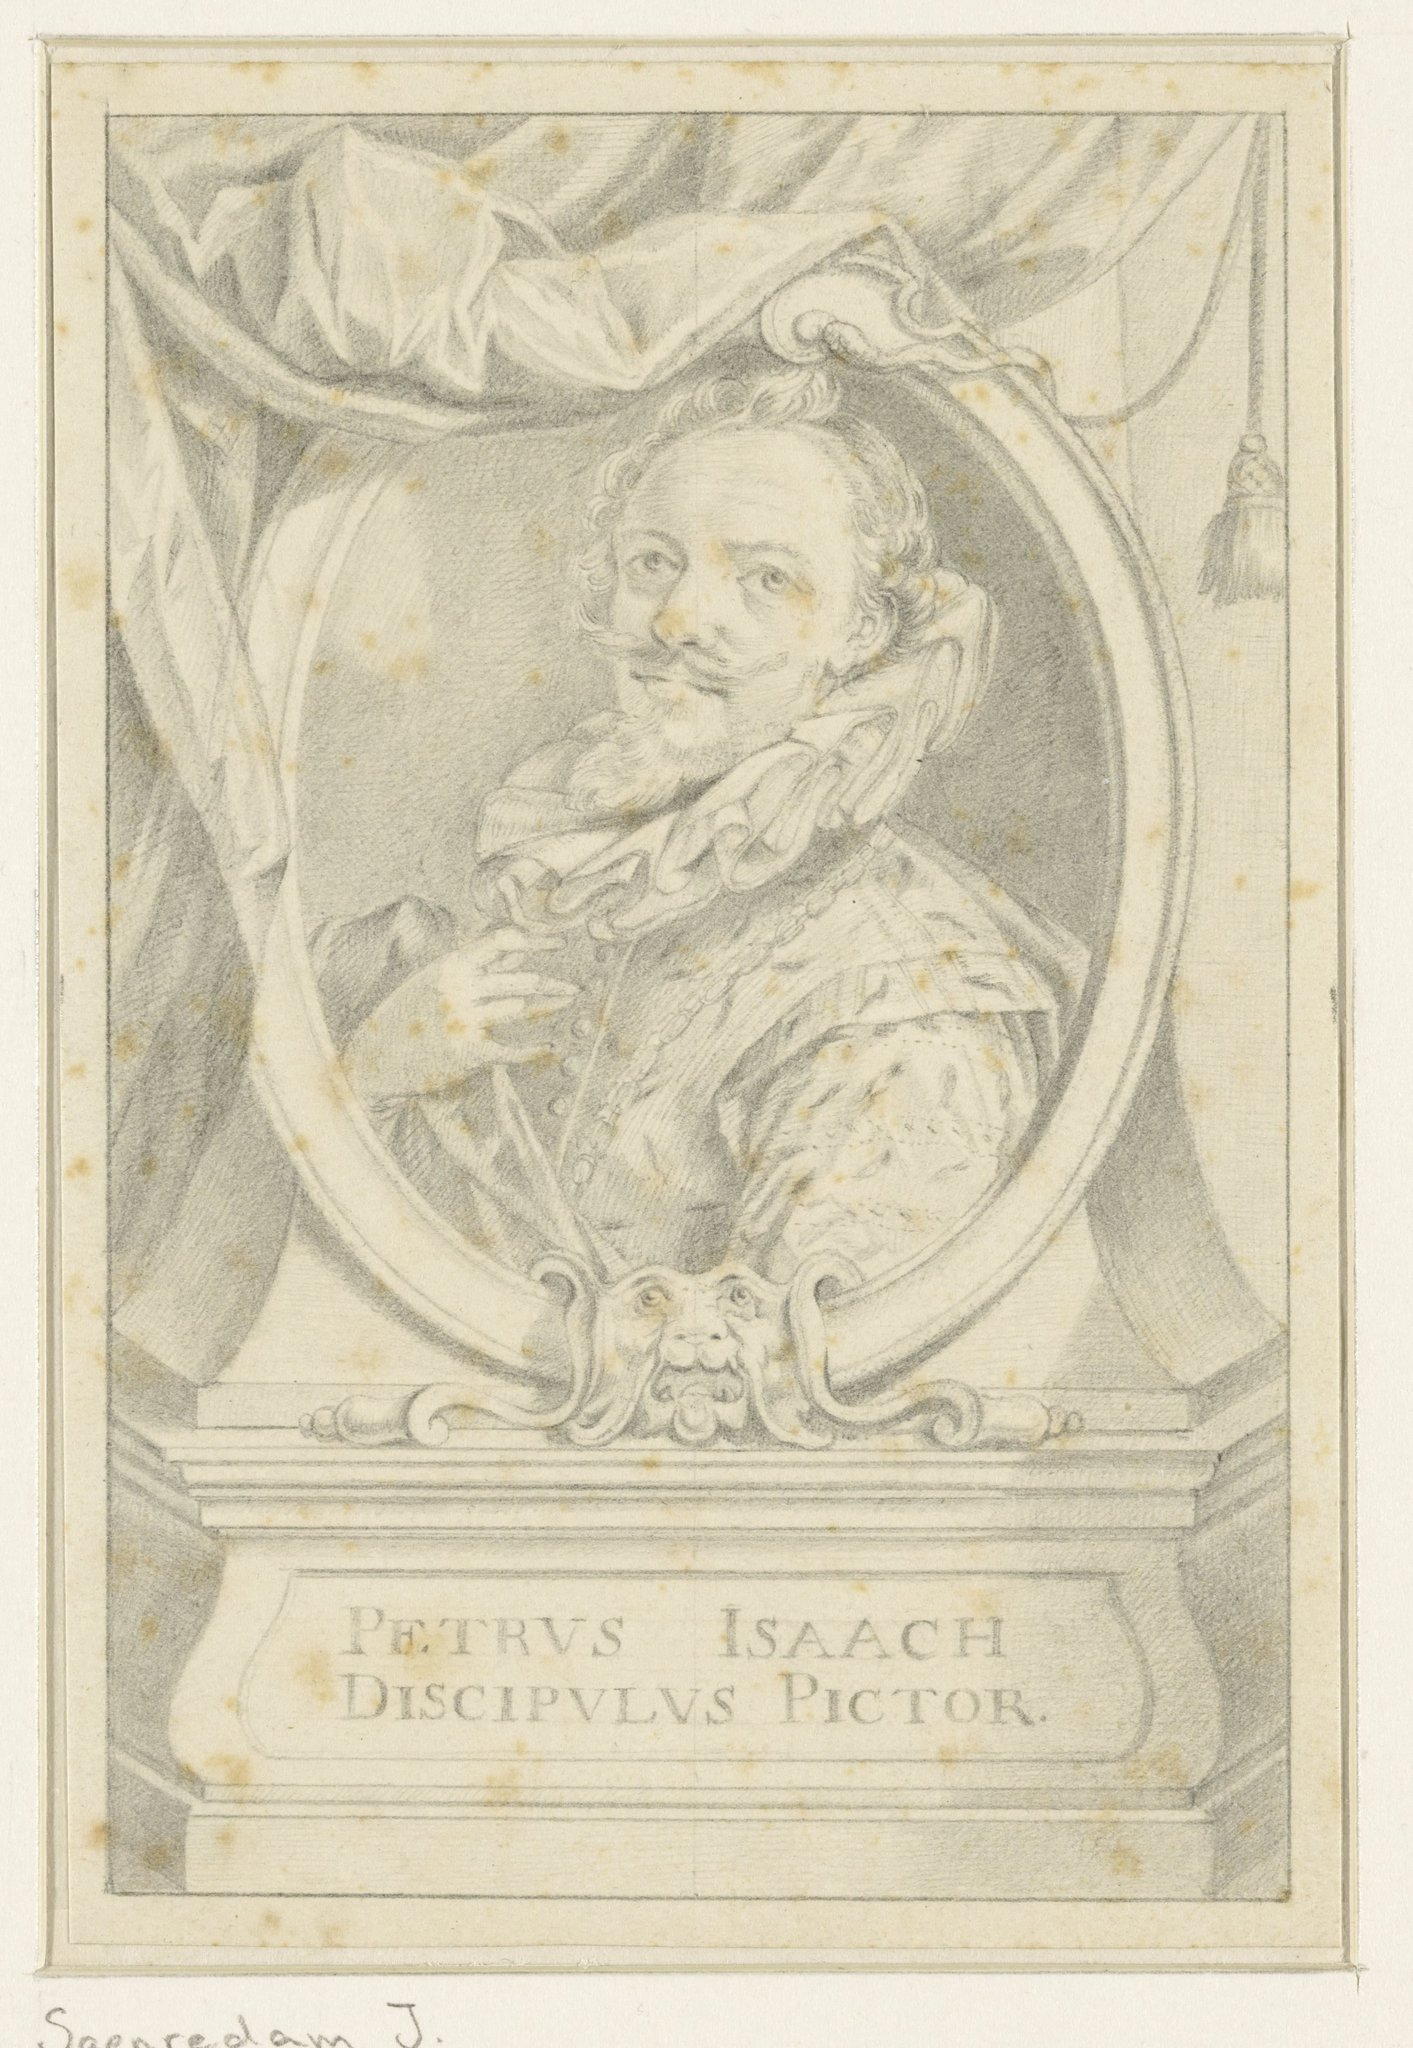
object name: drawing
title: Portret van Hans von Aachen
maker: Anonymous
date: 1601-1700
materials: paper, pencil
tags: cologne, prague, draughtsman, hans von aachen, historical persons, portrait, self-portrait of painter, portrait, self-portrait of artist